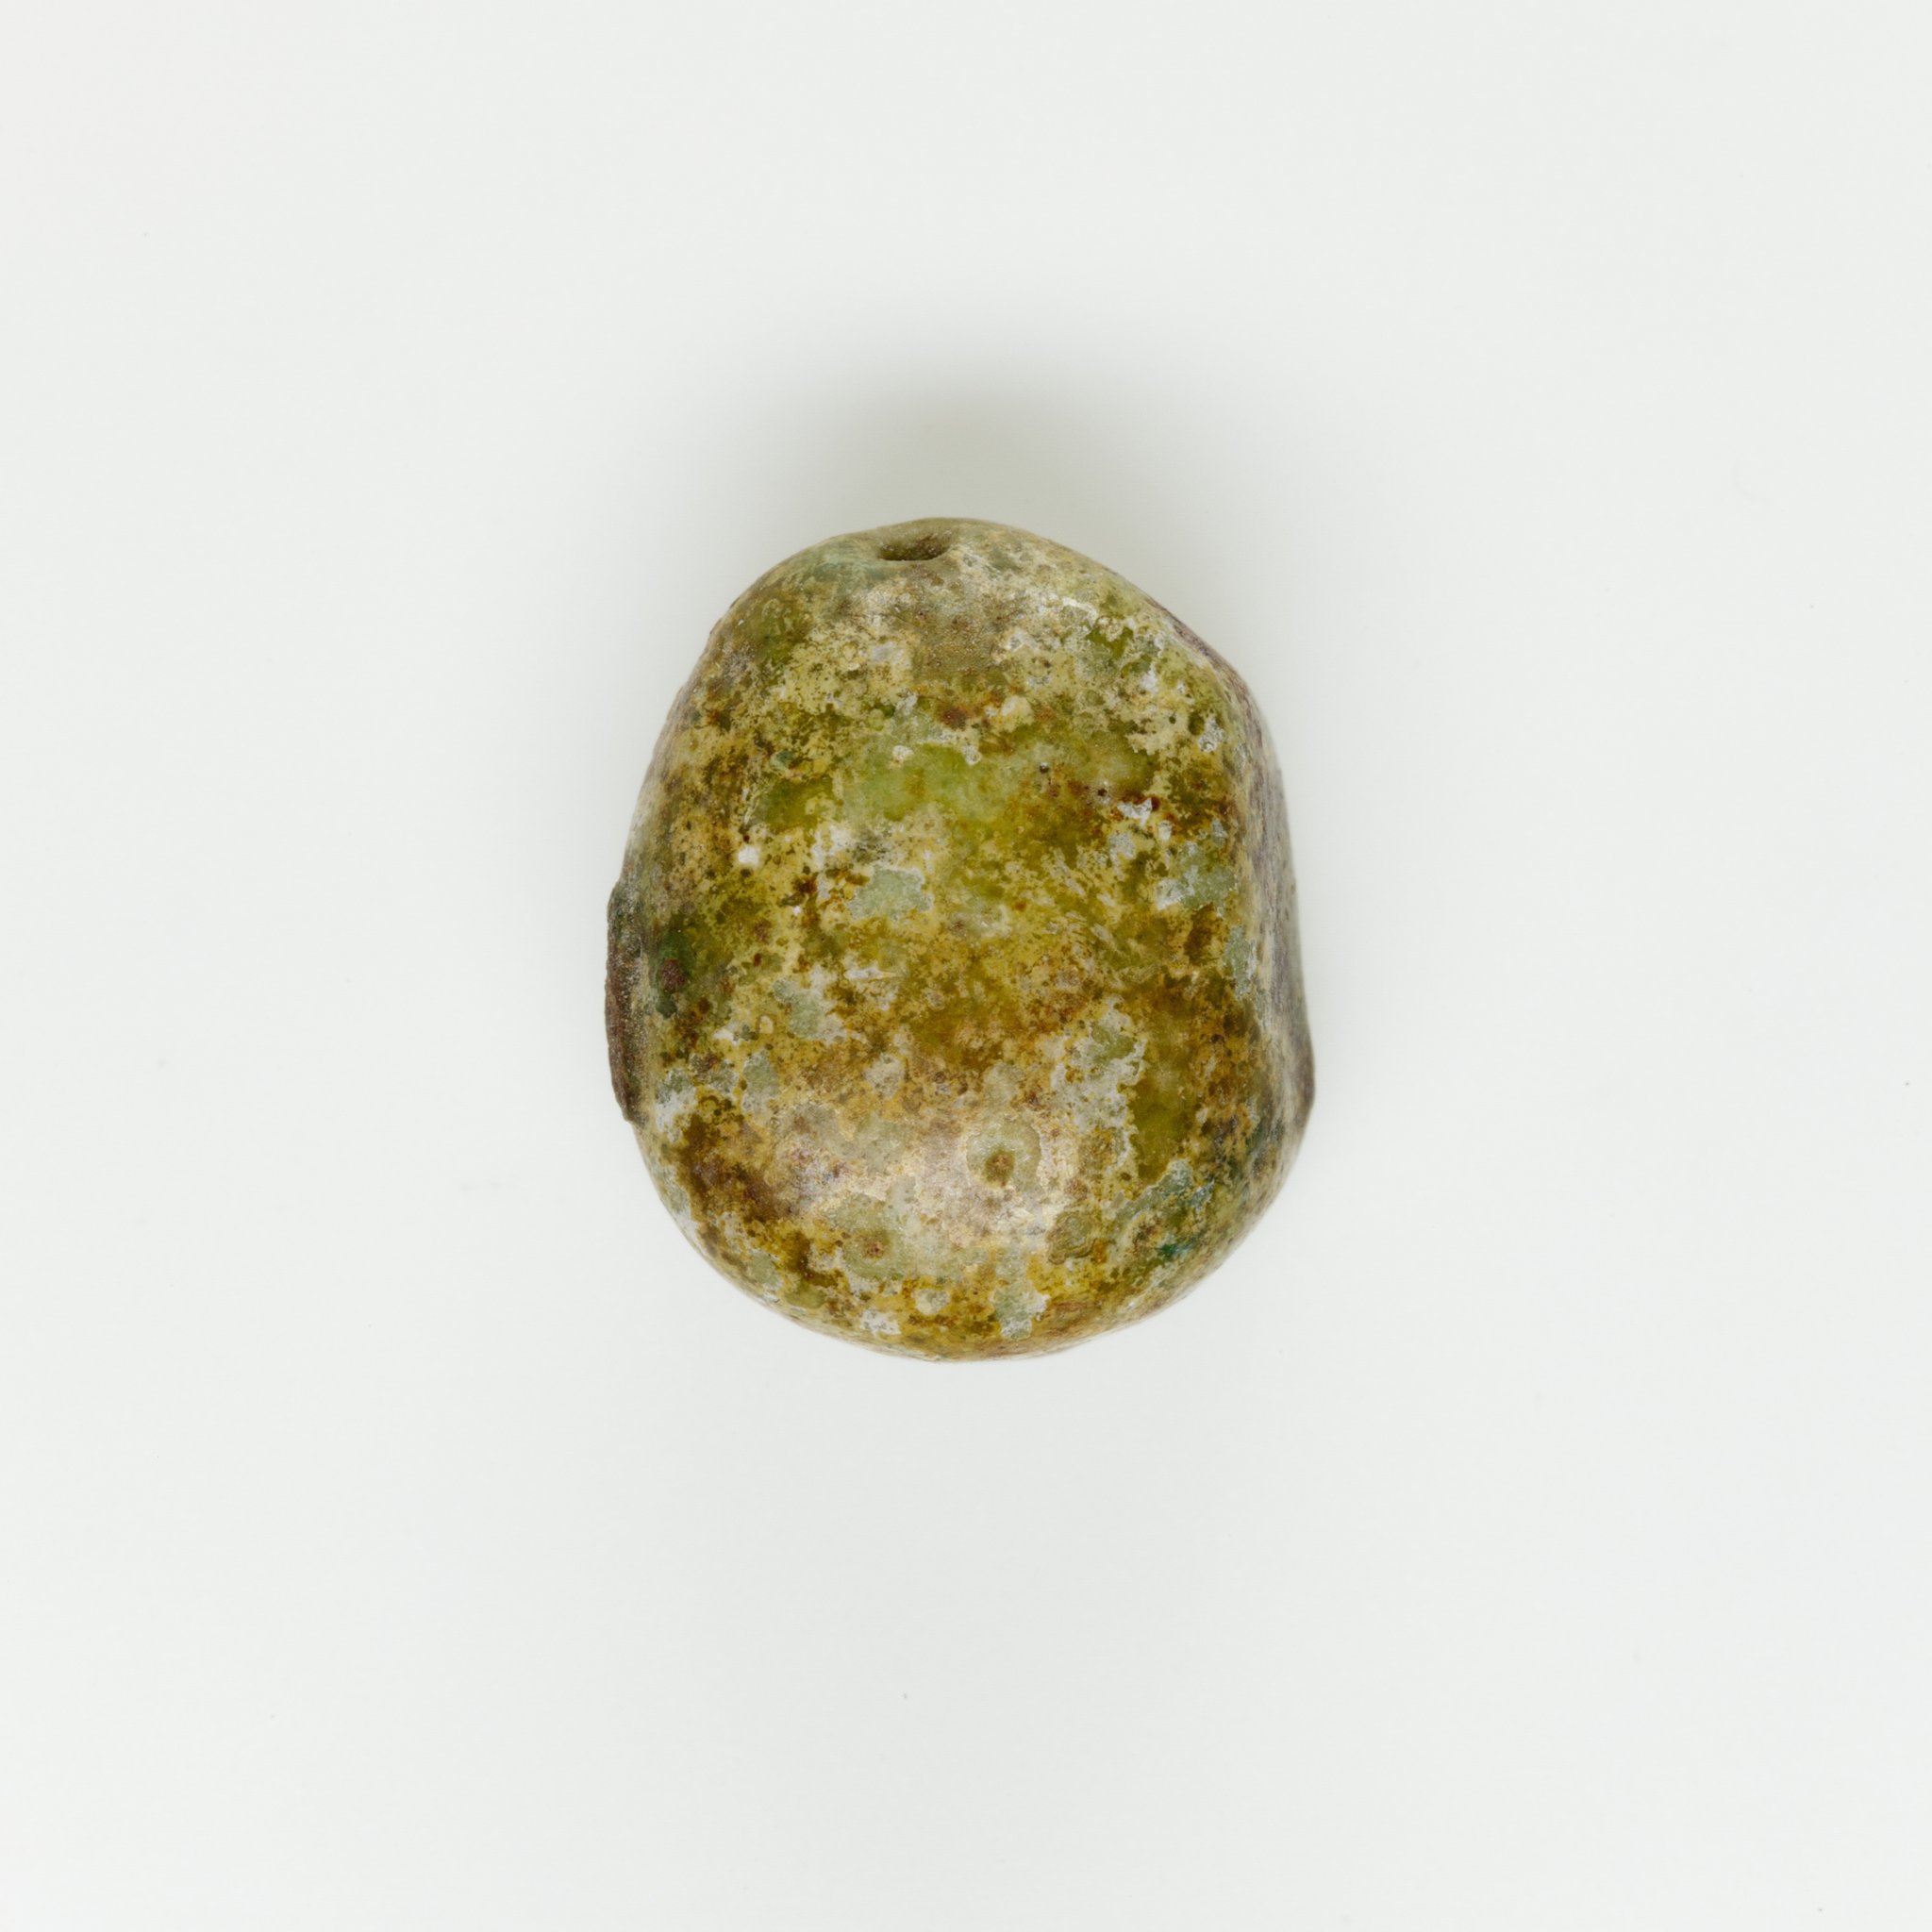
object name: bead, scarab, amenemhat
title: Uninscribed Scaraboid Bead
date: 1504-1447 BCE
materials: faience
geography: egypt